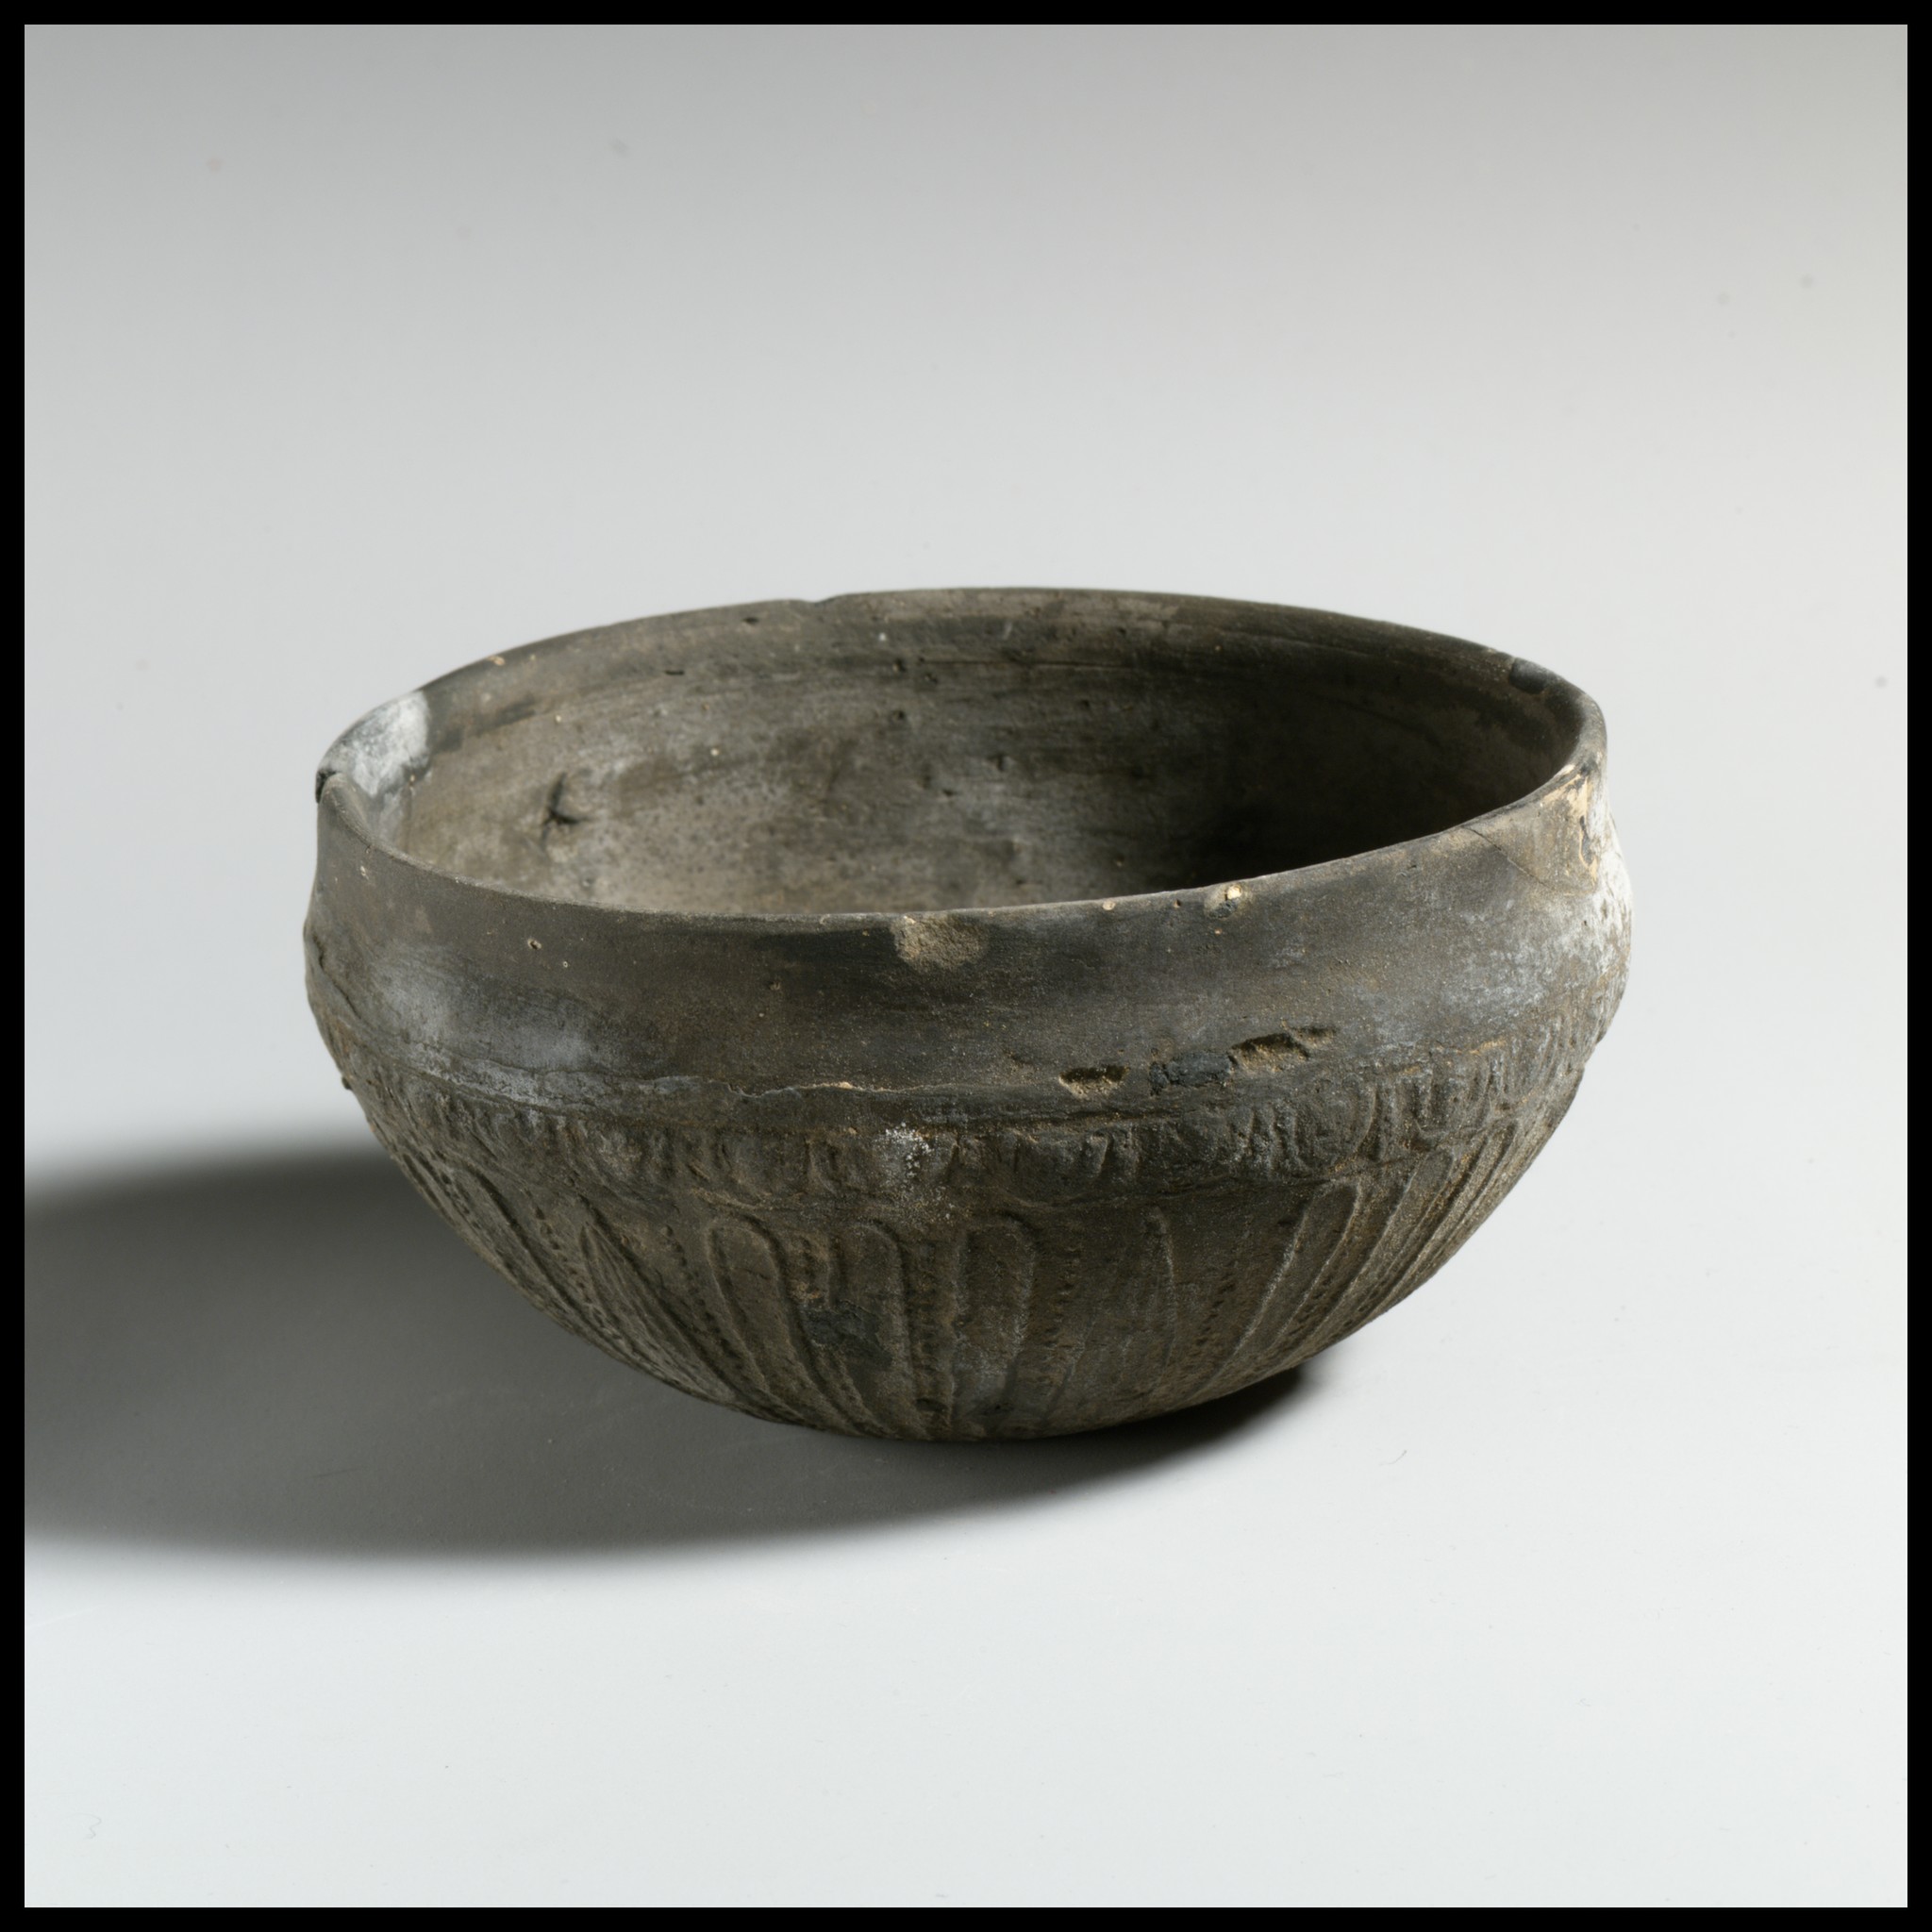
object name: bowl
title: Terracotta Megarian bowl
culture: greek, argive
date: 165-150 BCE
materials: terracotta